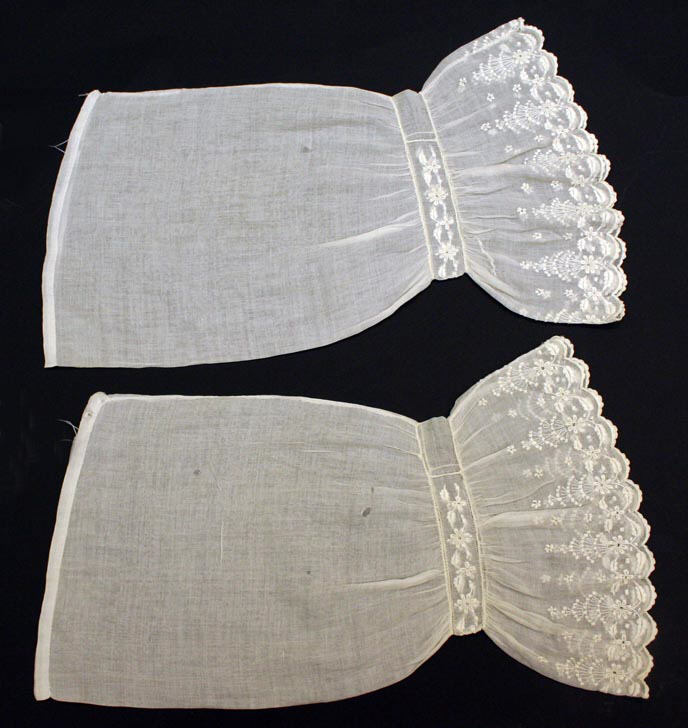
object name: undersleeves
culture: french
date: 1860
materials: linen